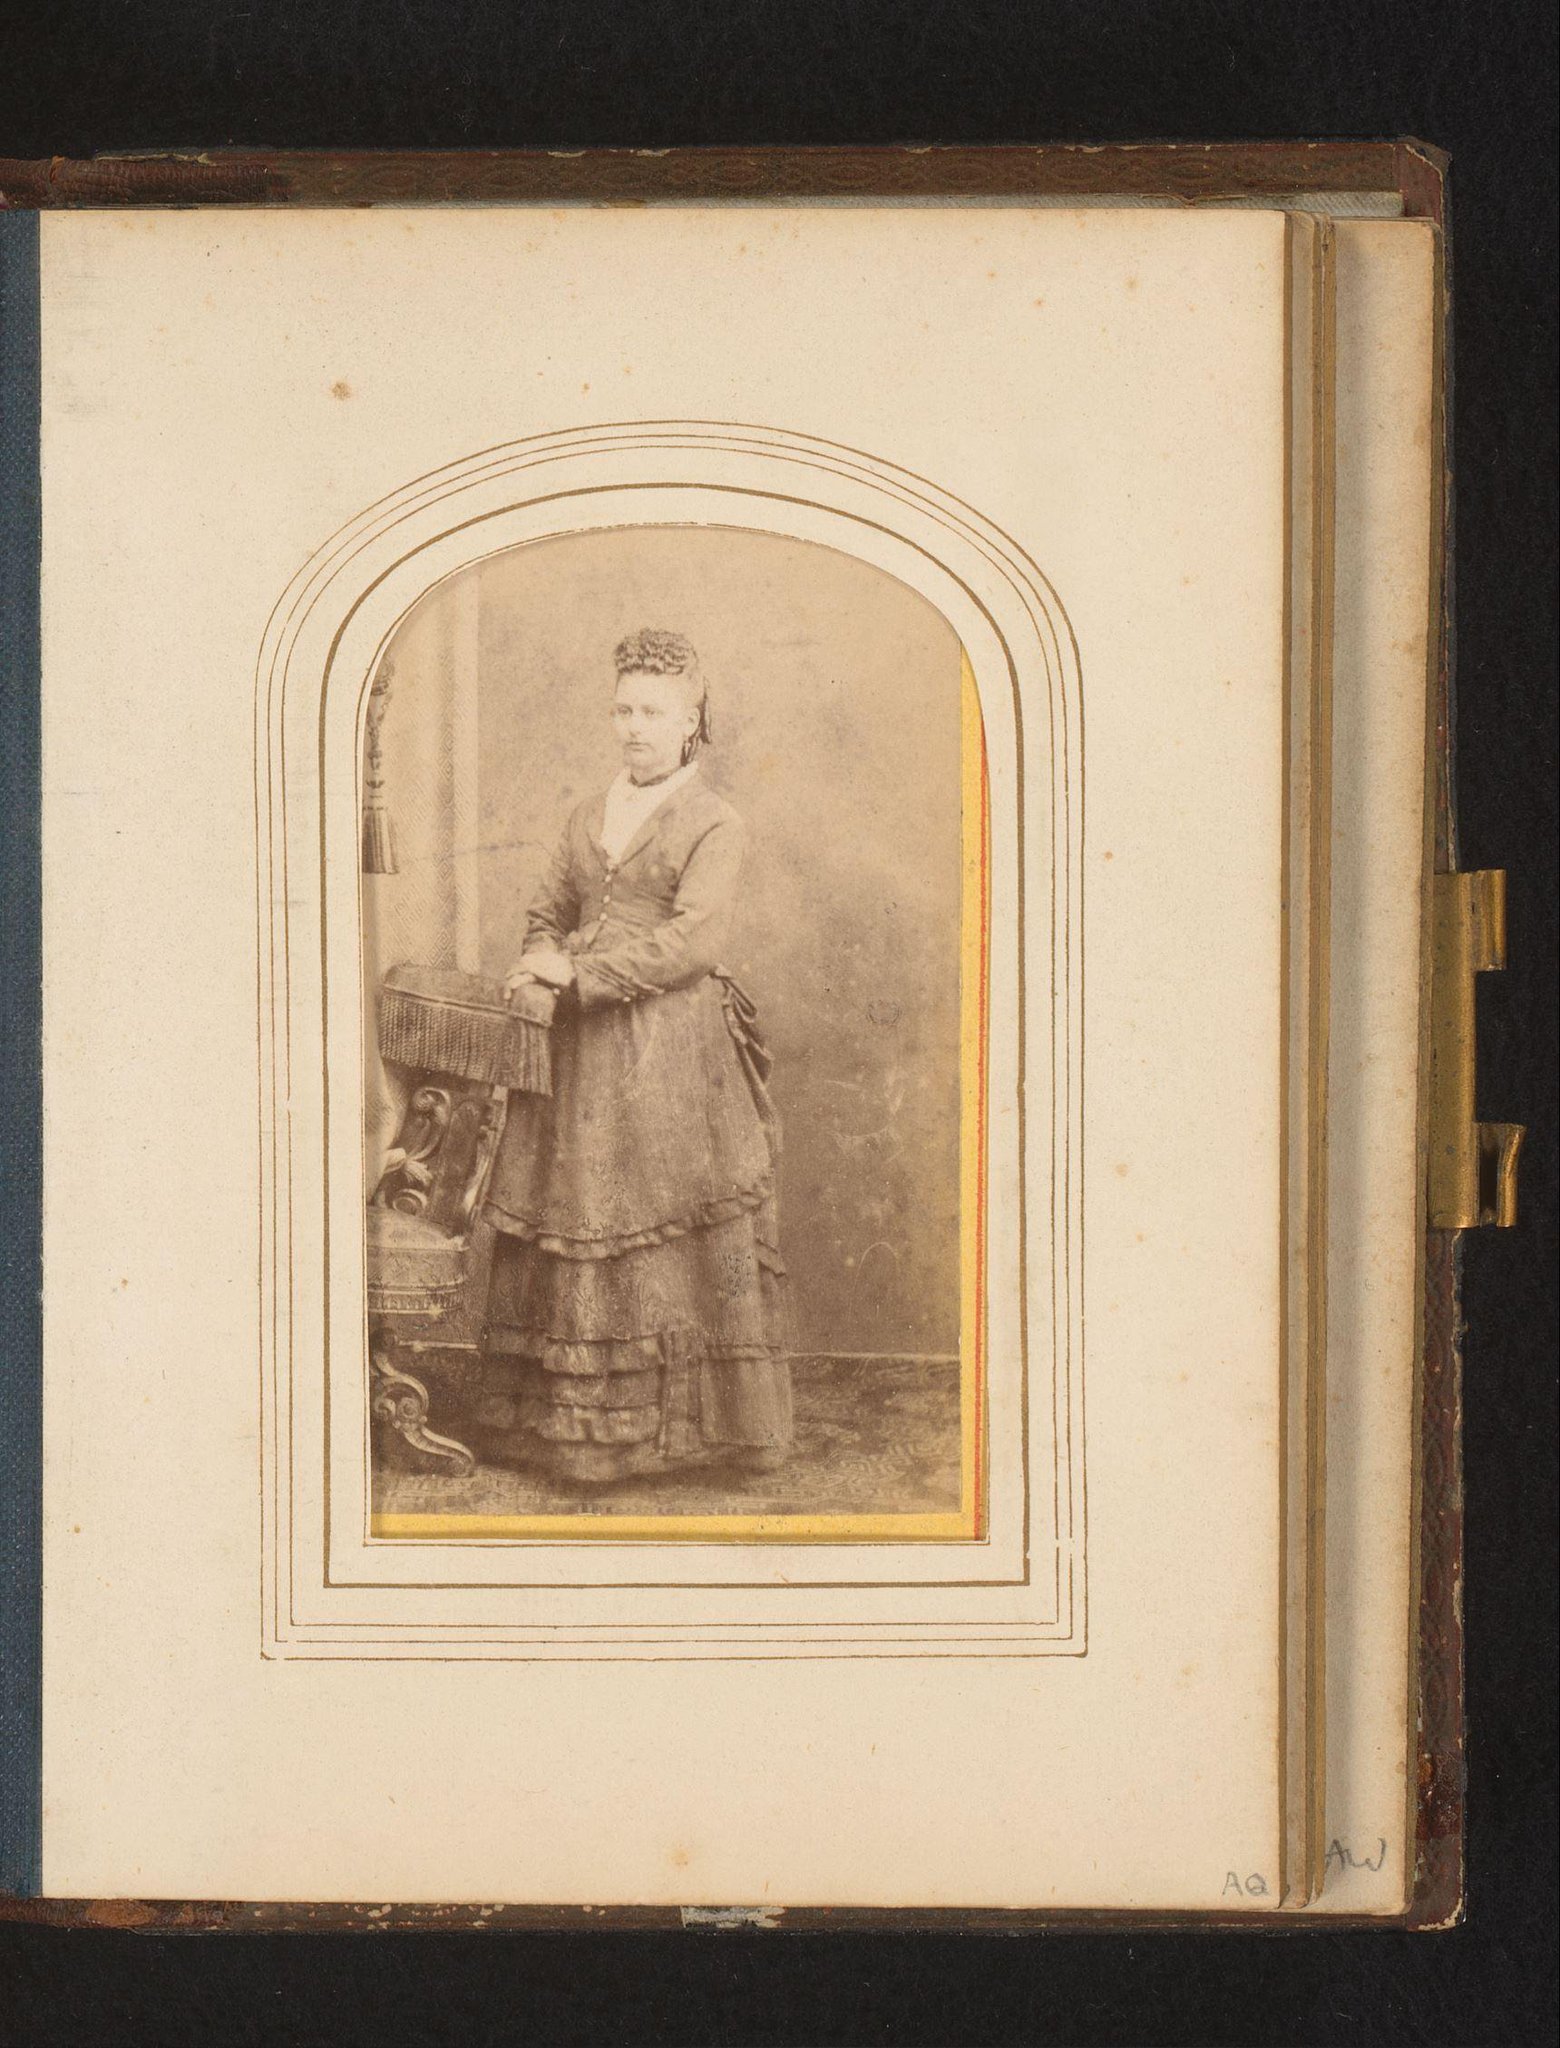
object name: album leaf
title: Portret van een vrouw, staand bij een stoel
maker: charles lemoine (fotograaf)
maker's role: fotograaf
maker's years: 1847-1917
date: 1860-1900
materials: cardboard, photographic support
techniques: albumen print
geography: veendam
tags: historical persons - bb - woman, standing figure - aa - female human figure, chair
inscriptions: inscription: ‘Photographie/ Steendrukkerij/ Ch. Lemoine/ VEENDAM’